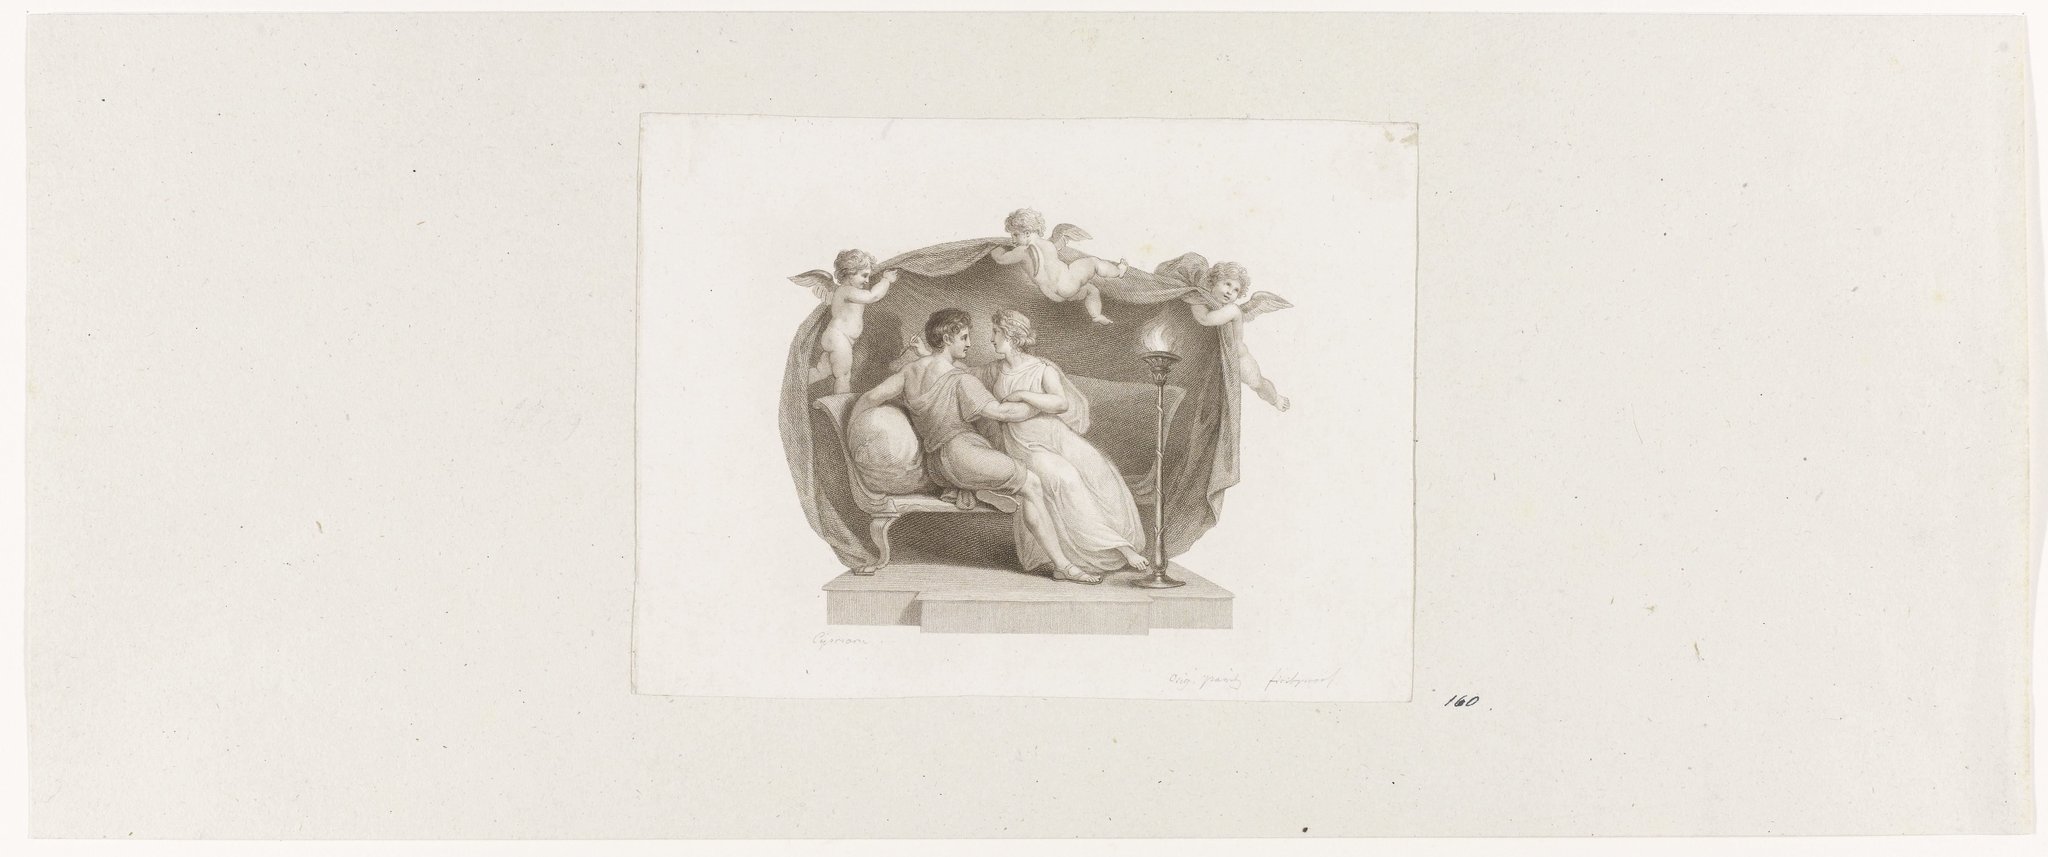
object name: print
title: Uitvinding van de tekenkunst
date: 1738-1815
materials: paper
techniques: etching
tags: the origin of painting and drawing, cupids: 'amores', 'amoretti', 'putti'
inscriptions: collector's mark: Lugt 2228, collector's mark: Lugt 2760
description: Een meid schildert de omtrek van de schaduw van haar minnaar op een doek dat wordt gedragen door drie putti.